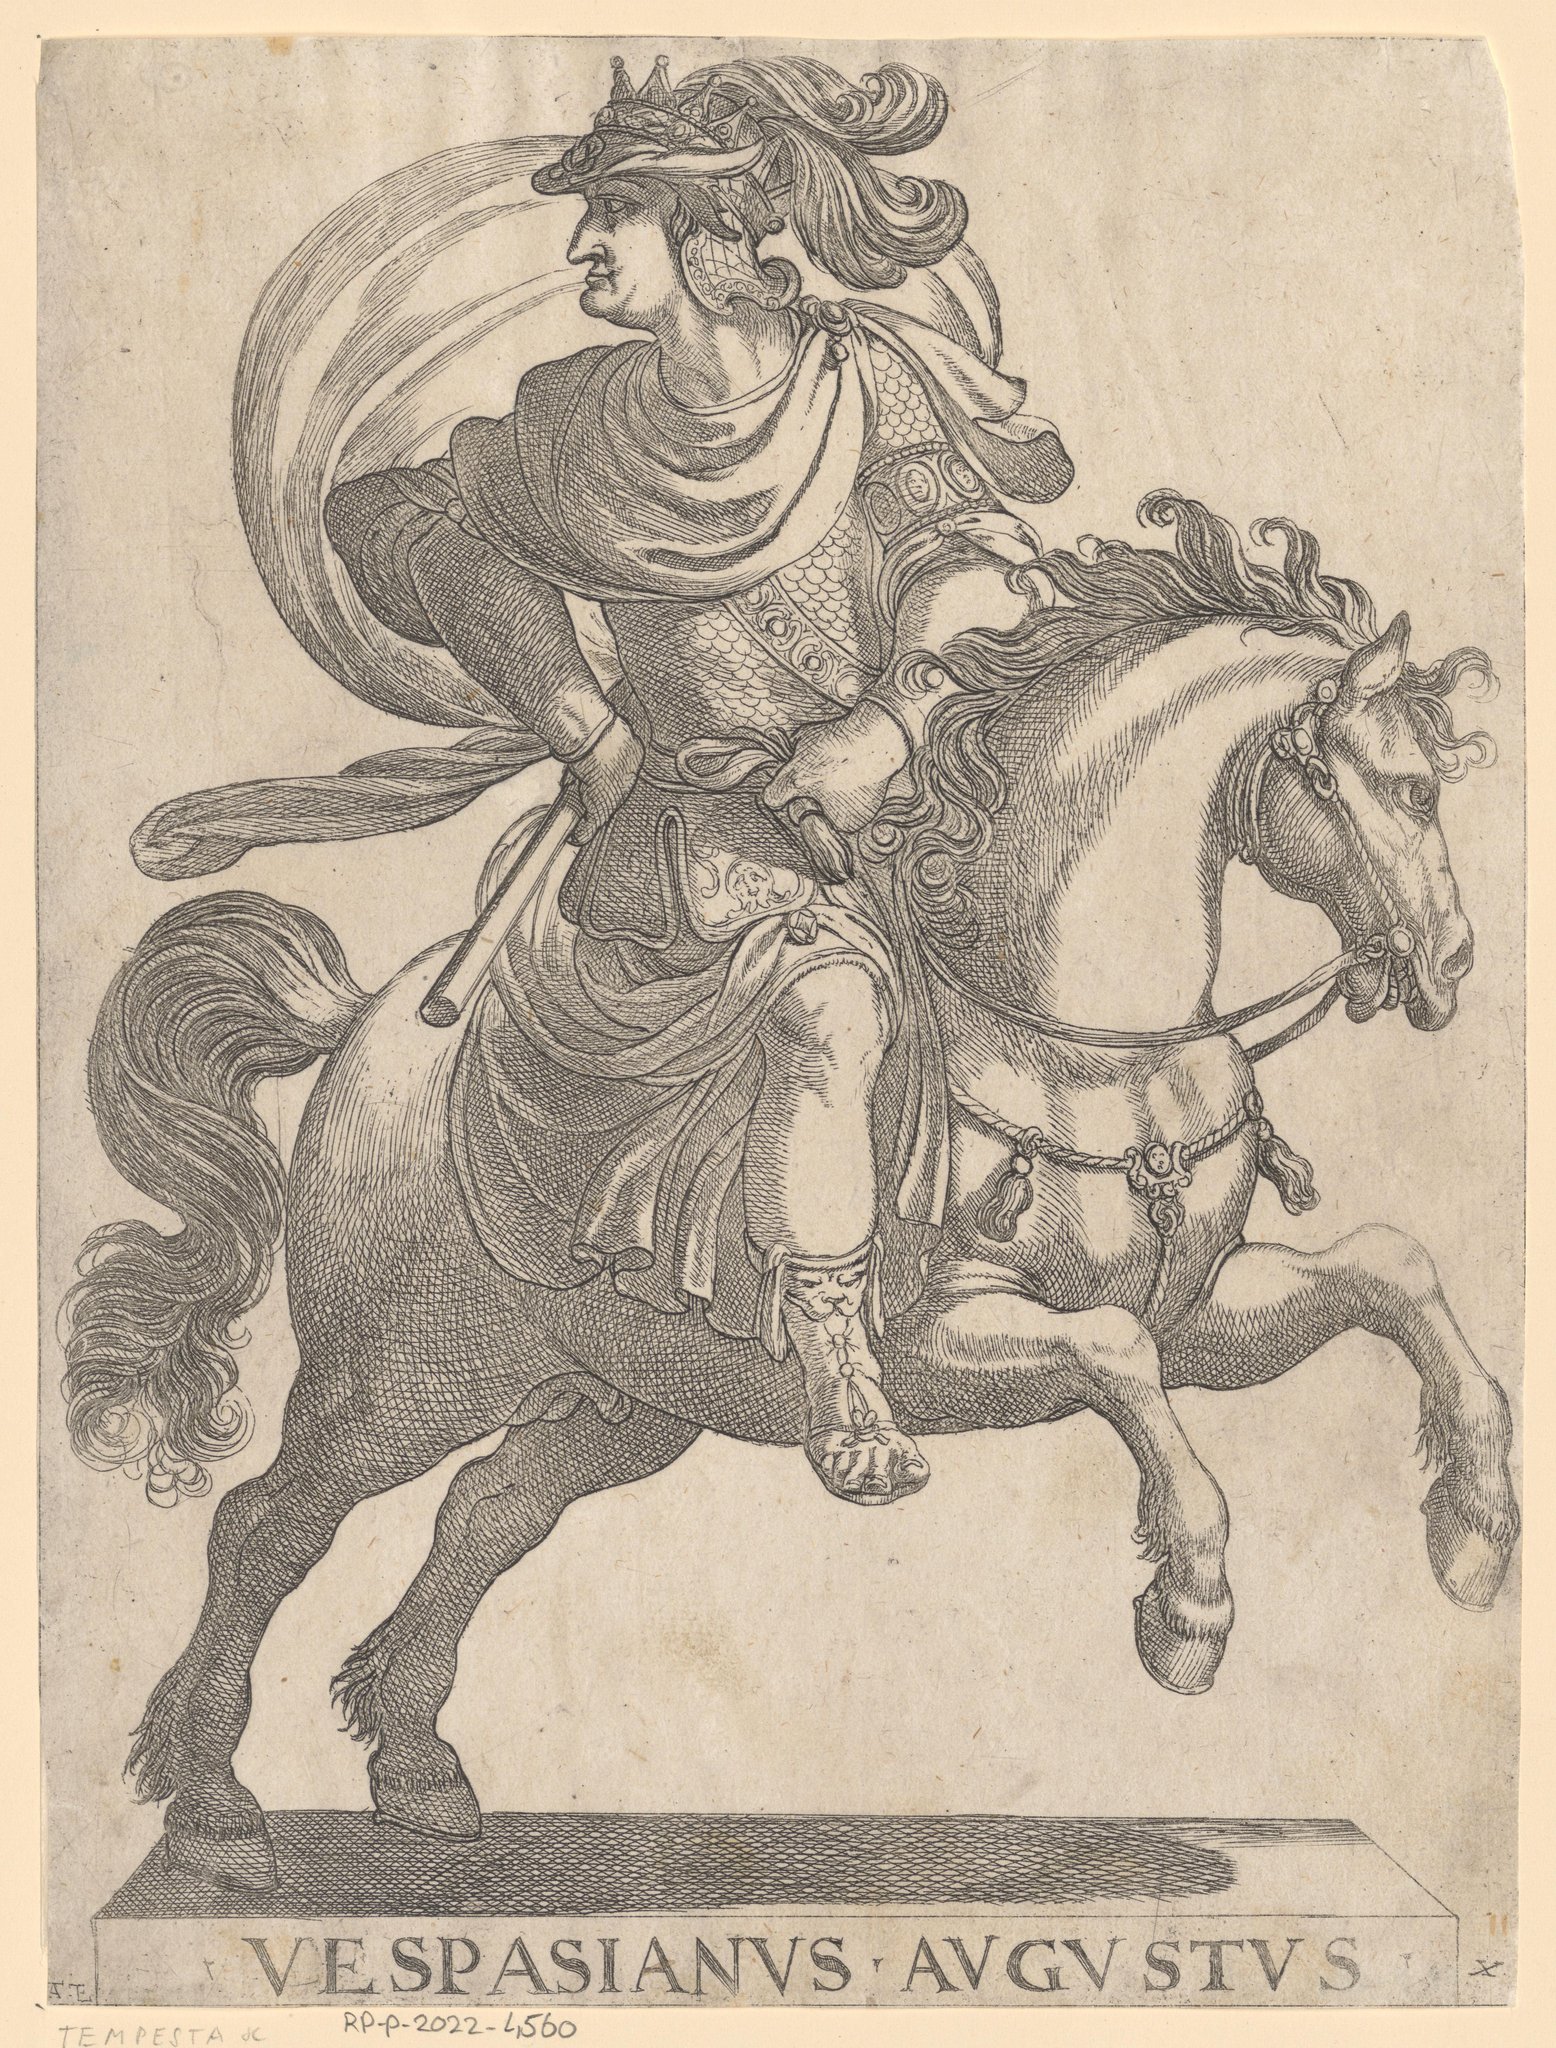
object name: print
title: Keizer Vespasianus te paard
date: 1596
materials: paper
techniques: etching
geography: italy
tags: portrait of vespasian, historical persons, equestrian statue